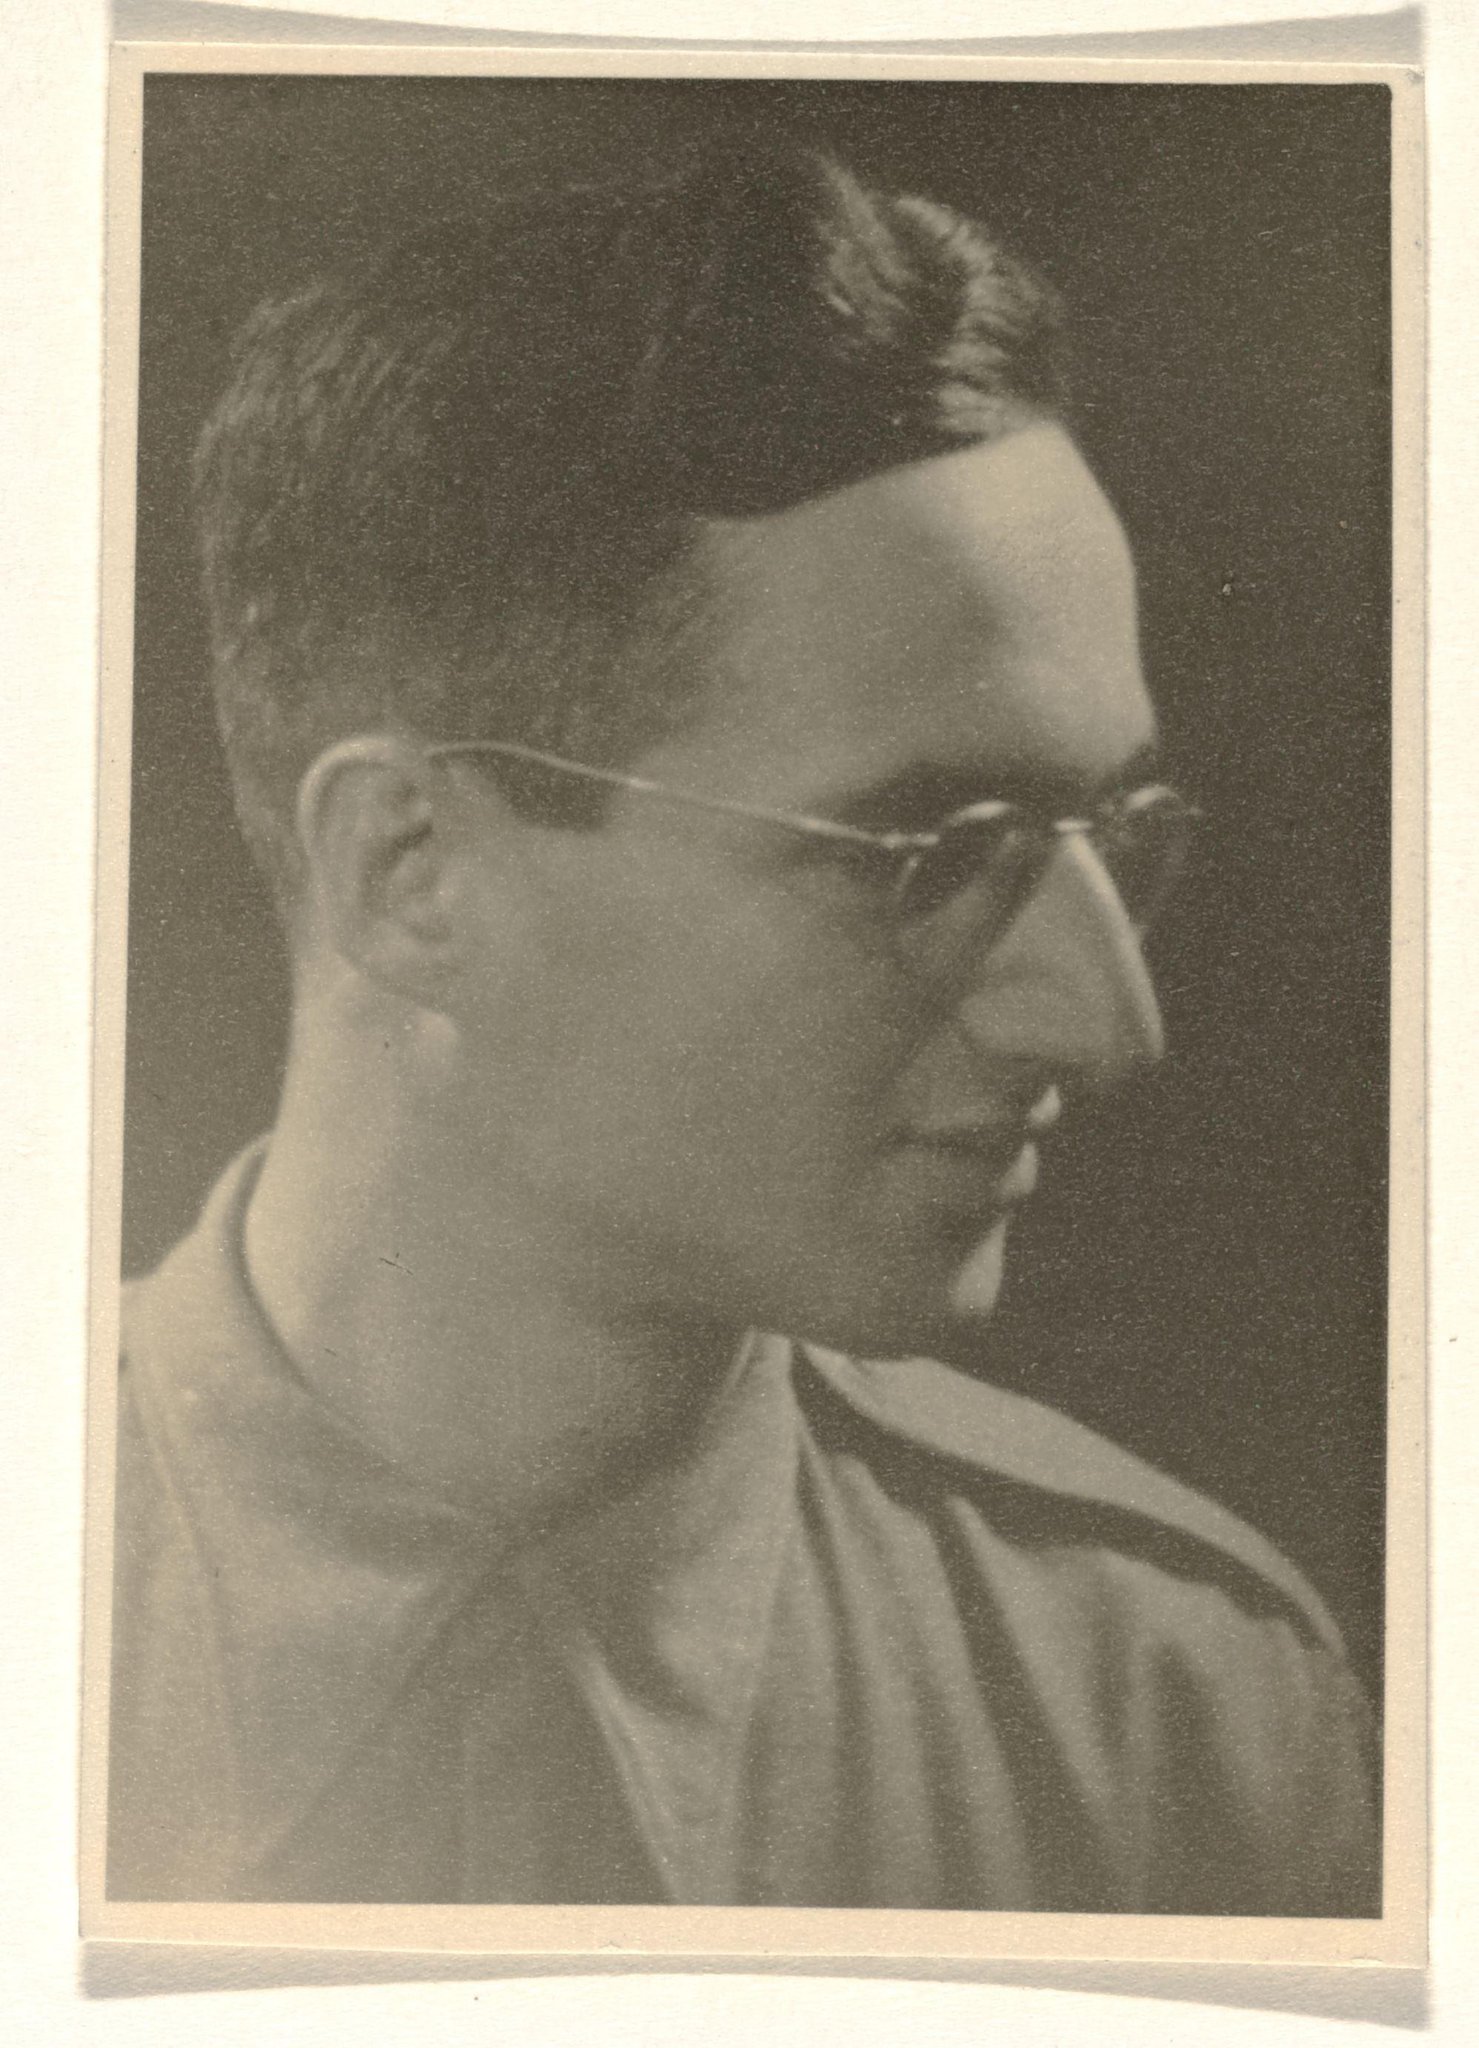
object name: photograph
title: Karl-Heinz Arndtheim, de tweede echtgenoot van Isabel Wachenheimer, en profil met bril en hemd met grote kraag,1949-1955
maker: Anonymous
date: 1949-1955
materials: photographic support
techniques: gelatin silver print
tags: karl-heinz arndtheim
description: Karl-Heinz Arndtheim, de tweede echtgenoot van Isabel Wachenheimer, en profil met bril en hemd met grote kraag.